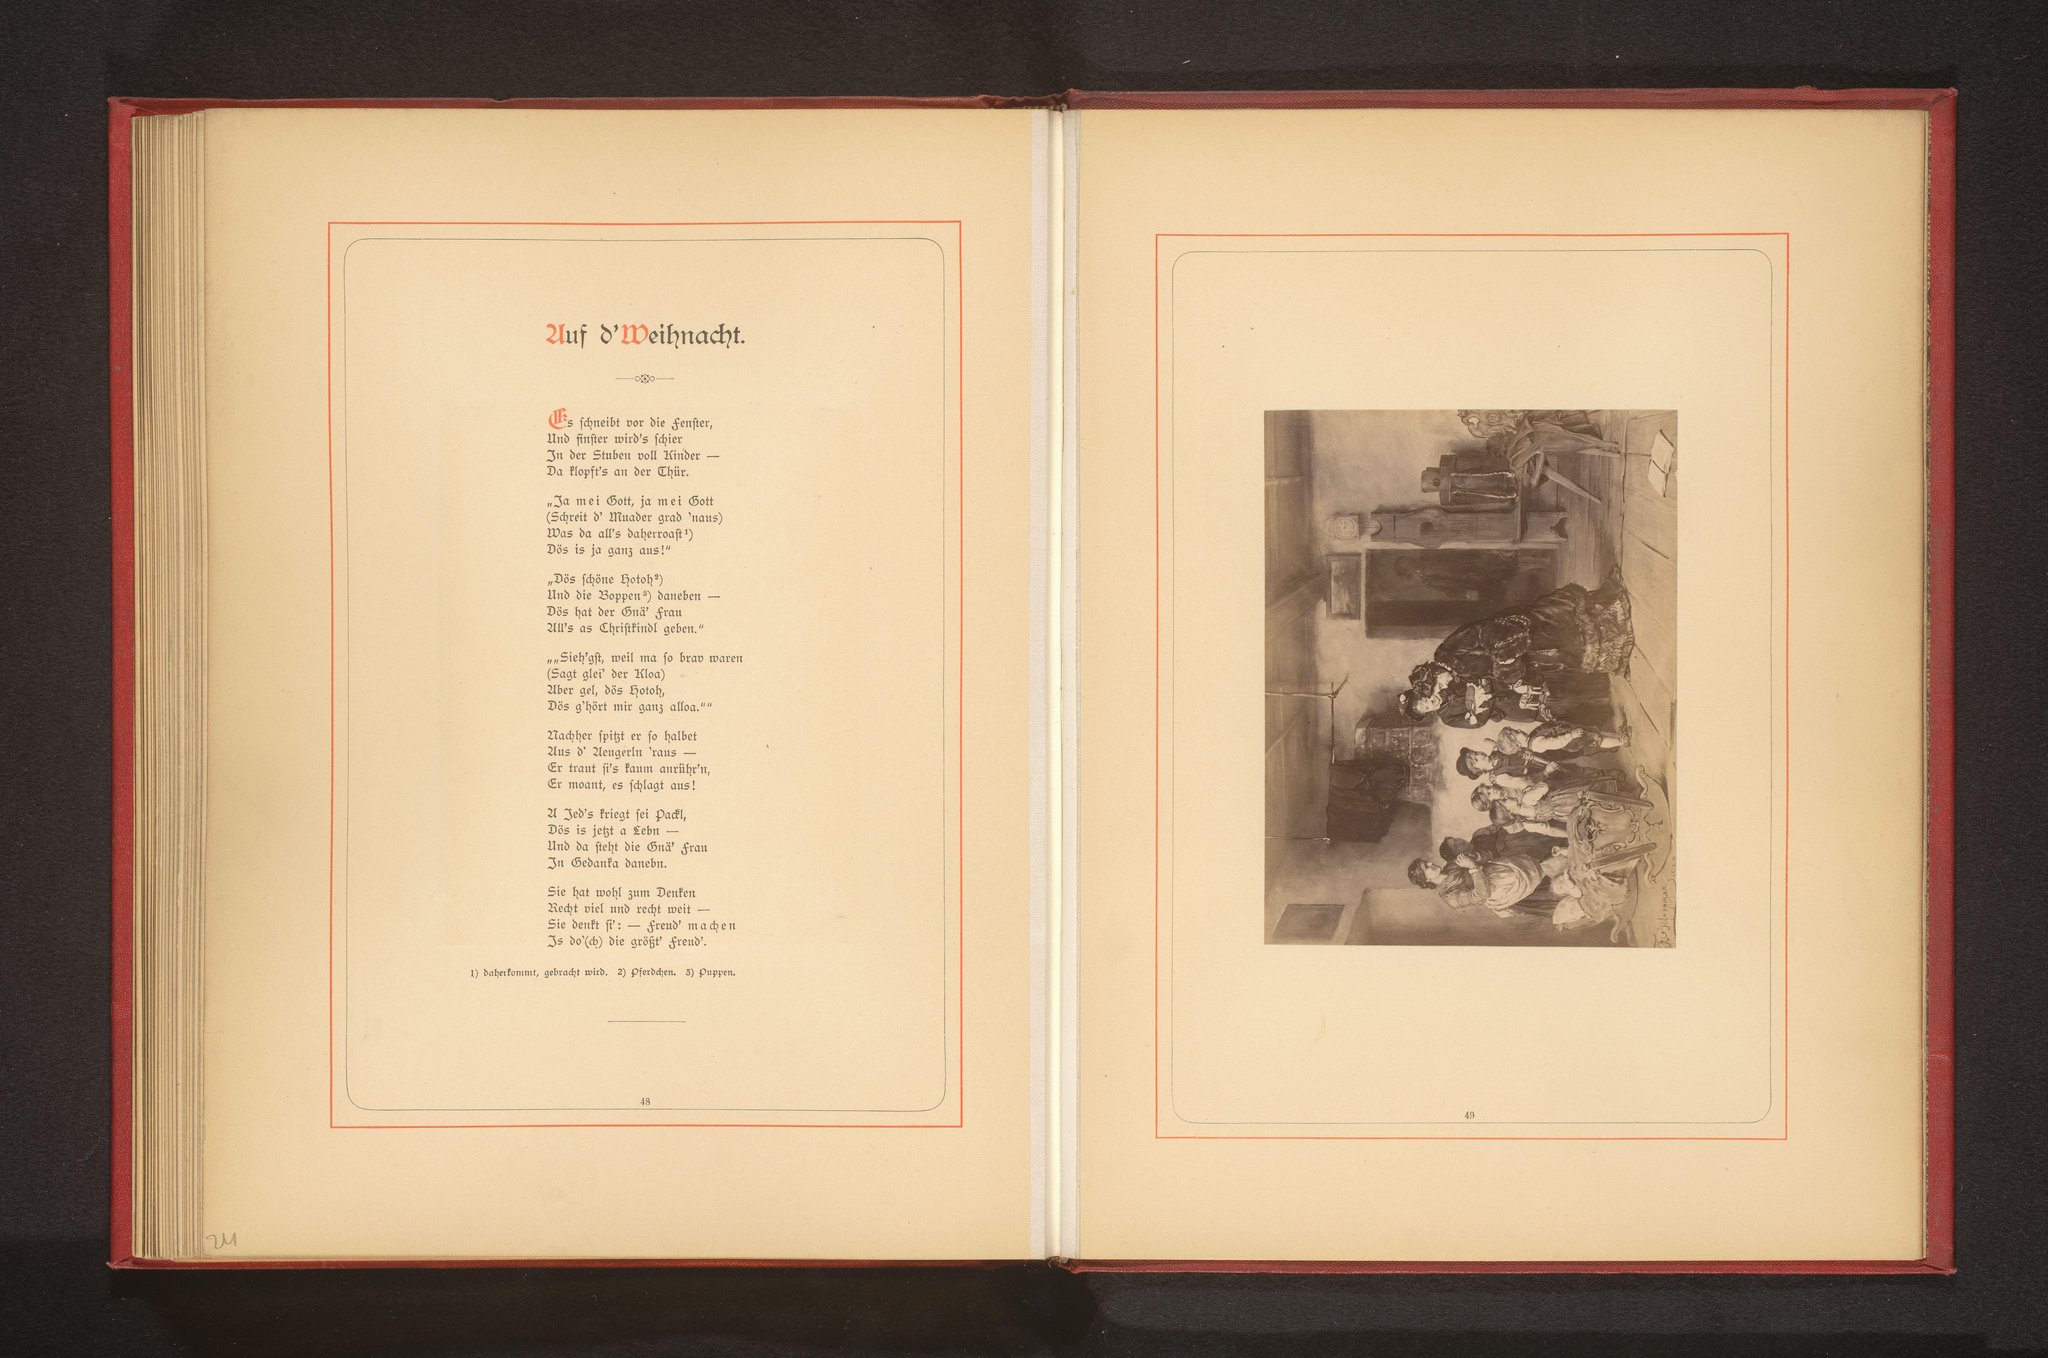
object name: reproduction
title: Fotoreproductie van een schilderij, voorstellende kinderen ontvangen geschenken tijdens Kerstmis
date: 1882-1883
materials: photographic support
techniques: albumen print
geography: germany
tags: christmas (non-liturgical celebration), bringing gifts; exchanging gifts, child (at home)